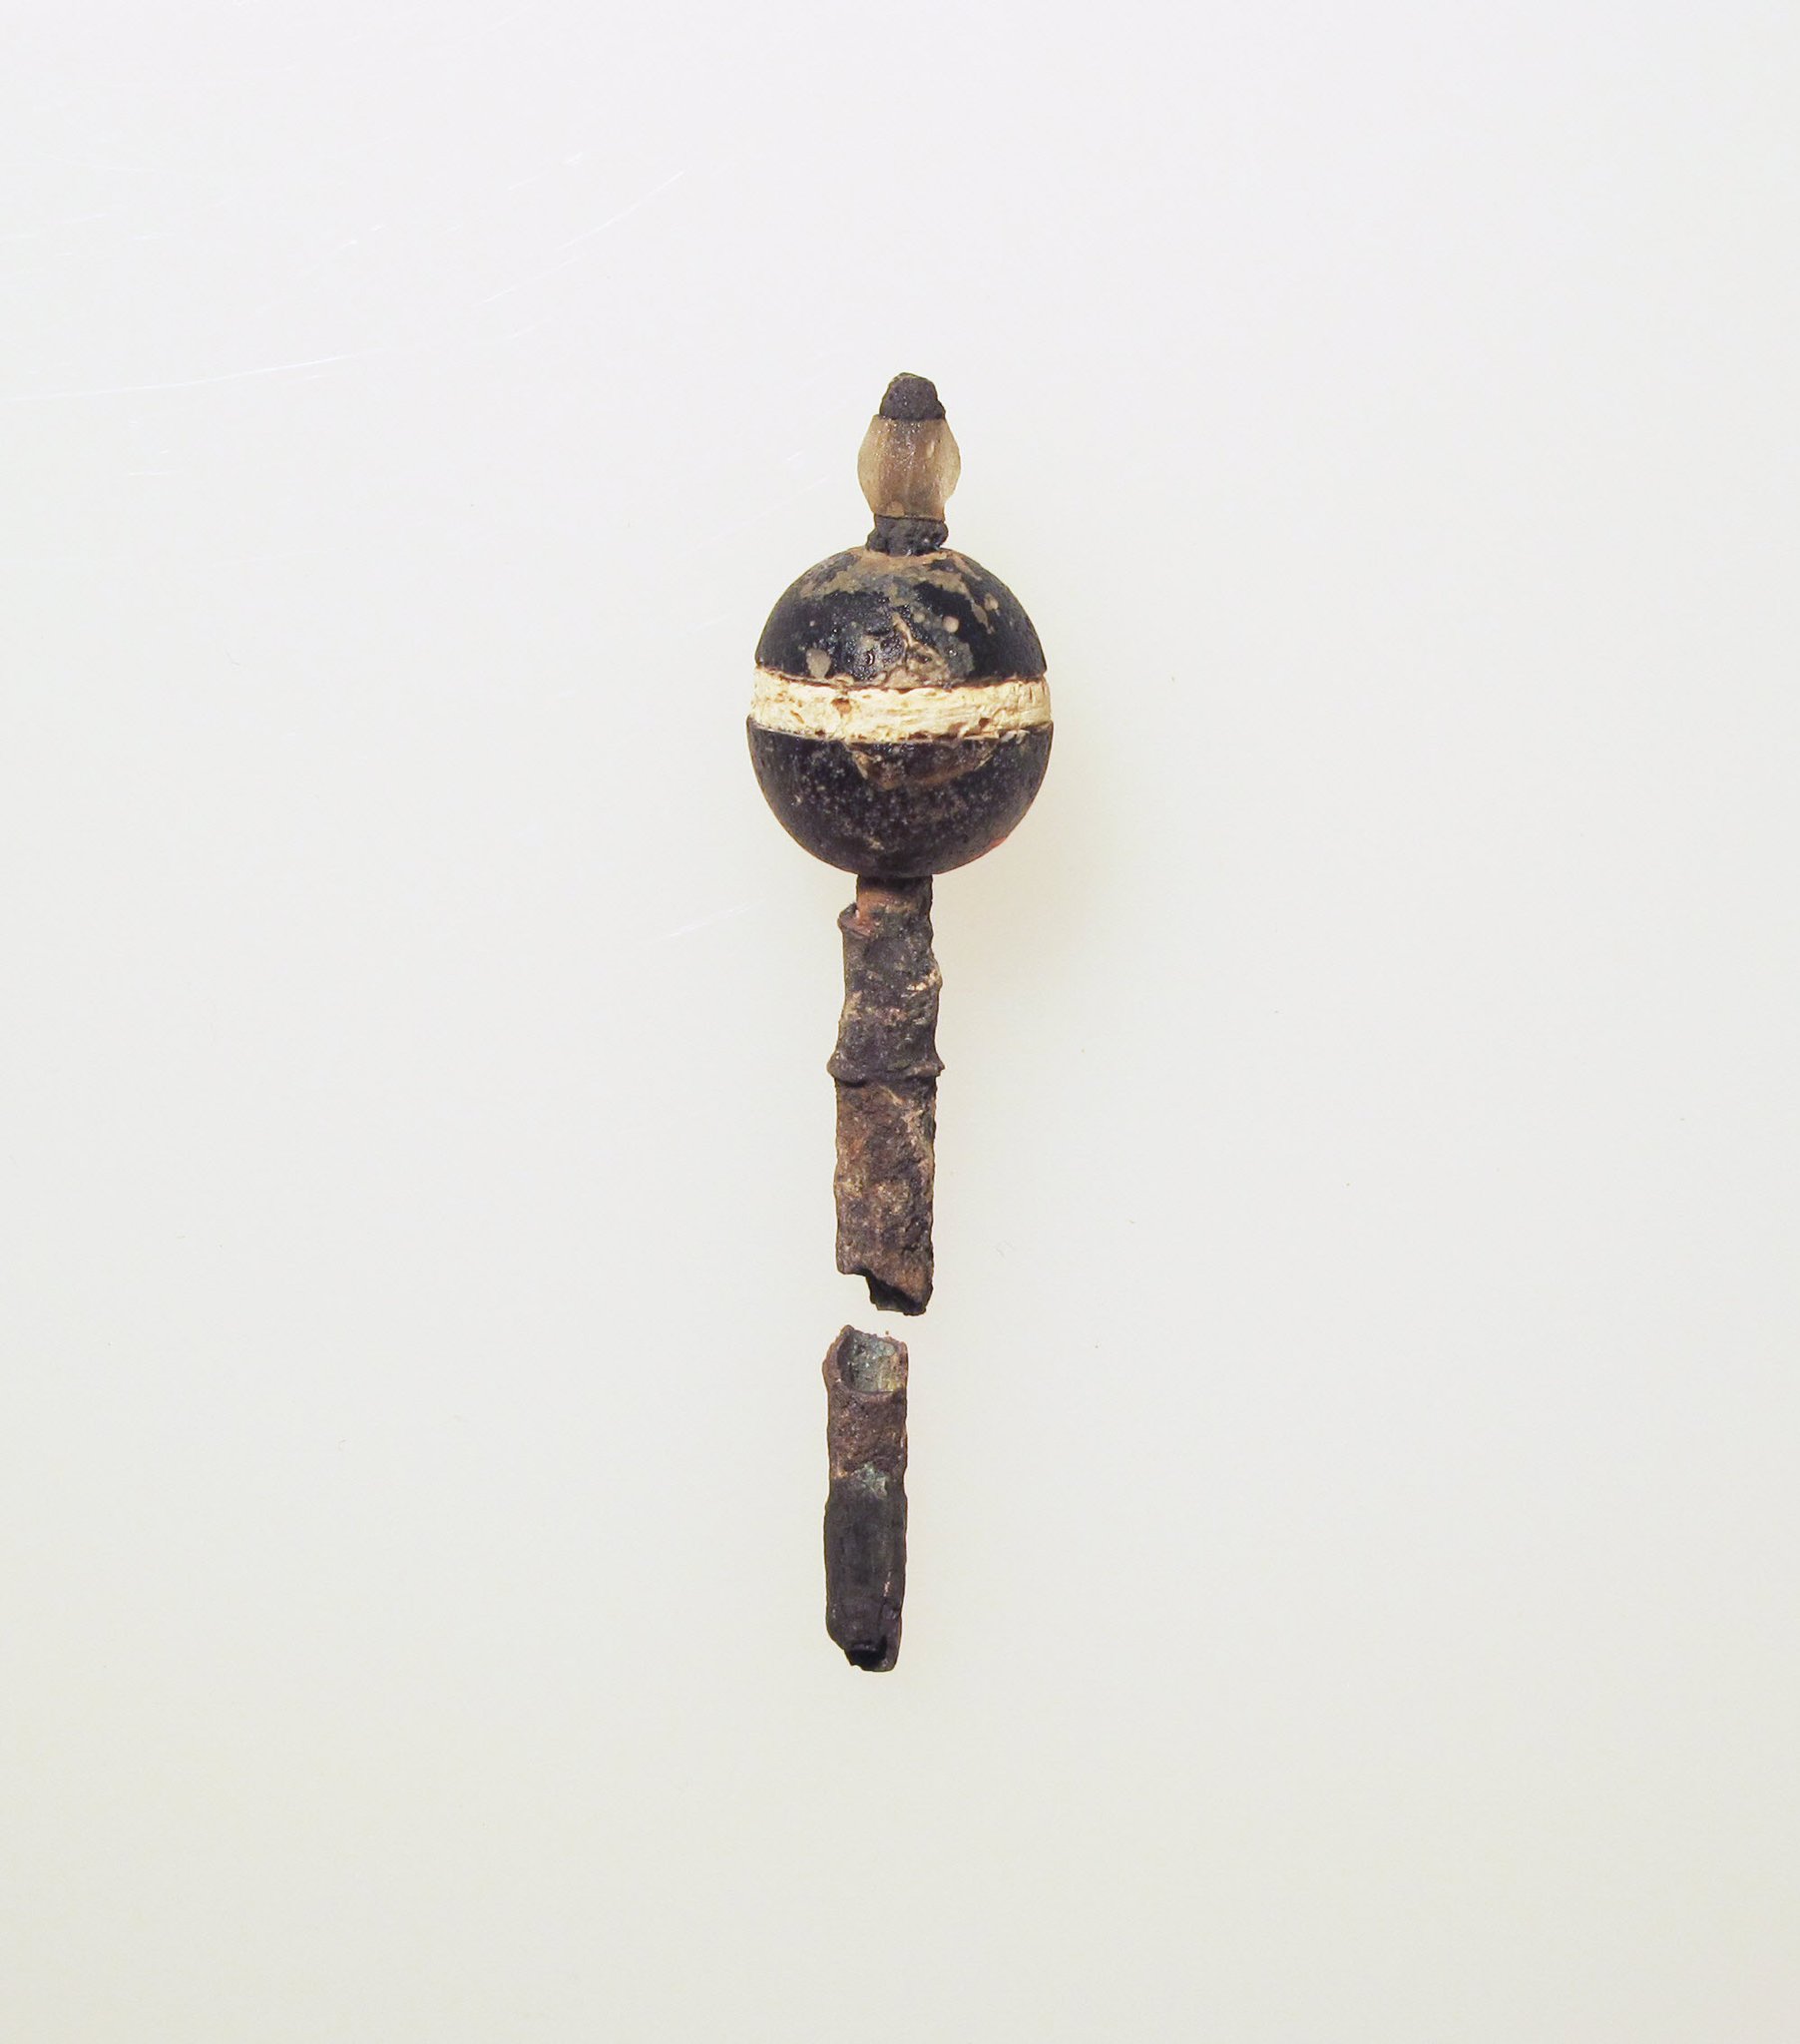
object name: hair pin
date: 7000 BCE-330 CE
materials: glass, onyx, paste, silver